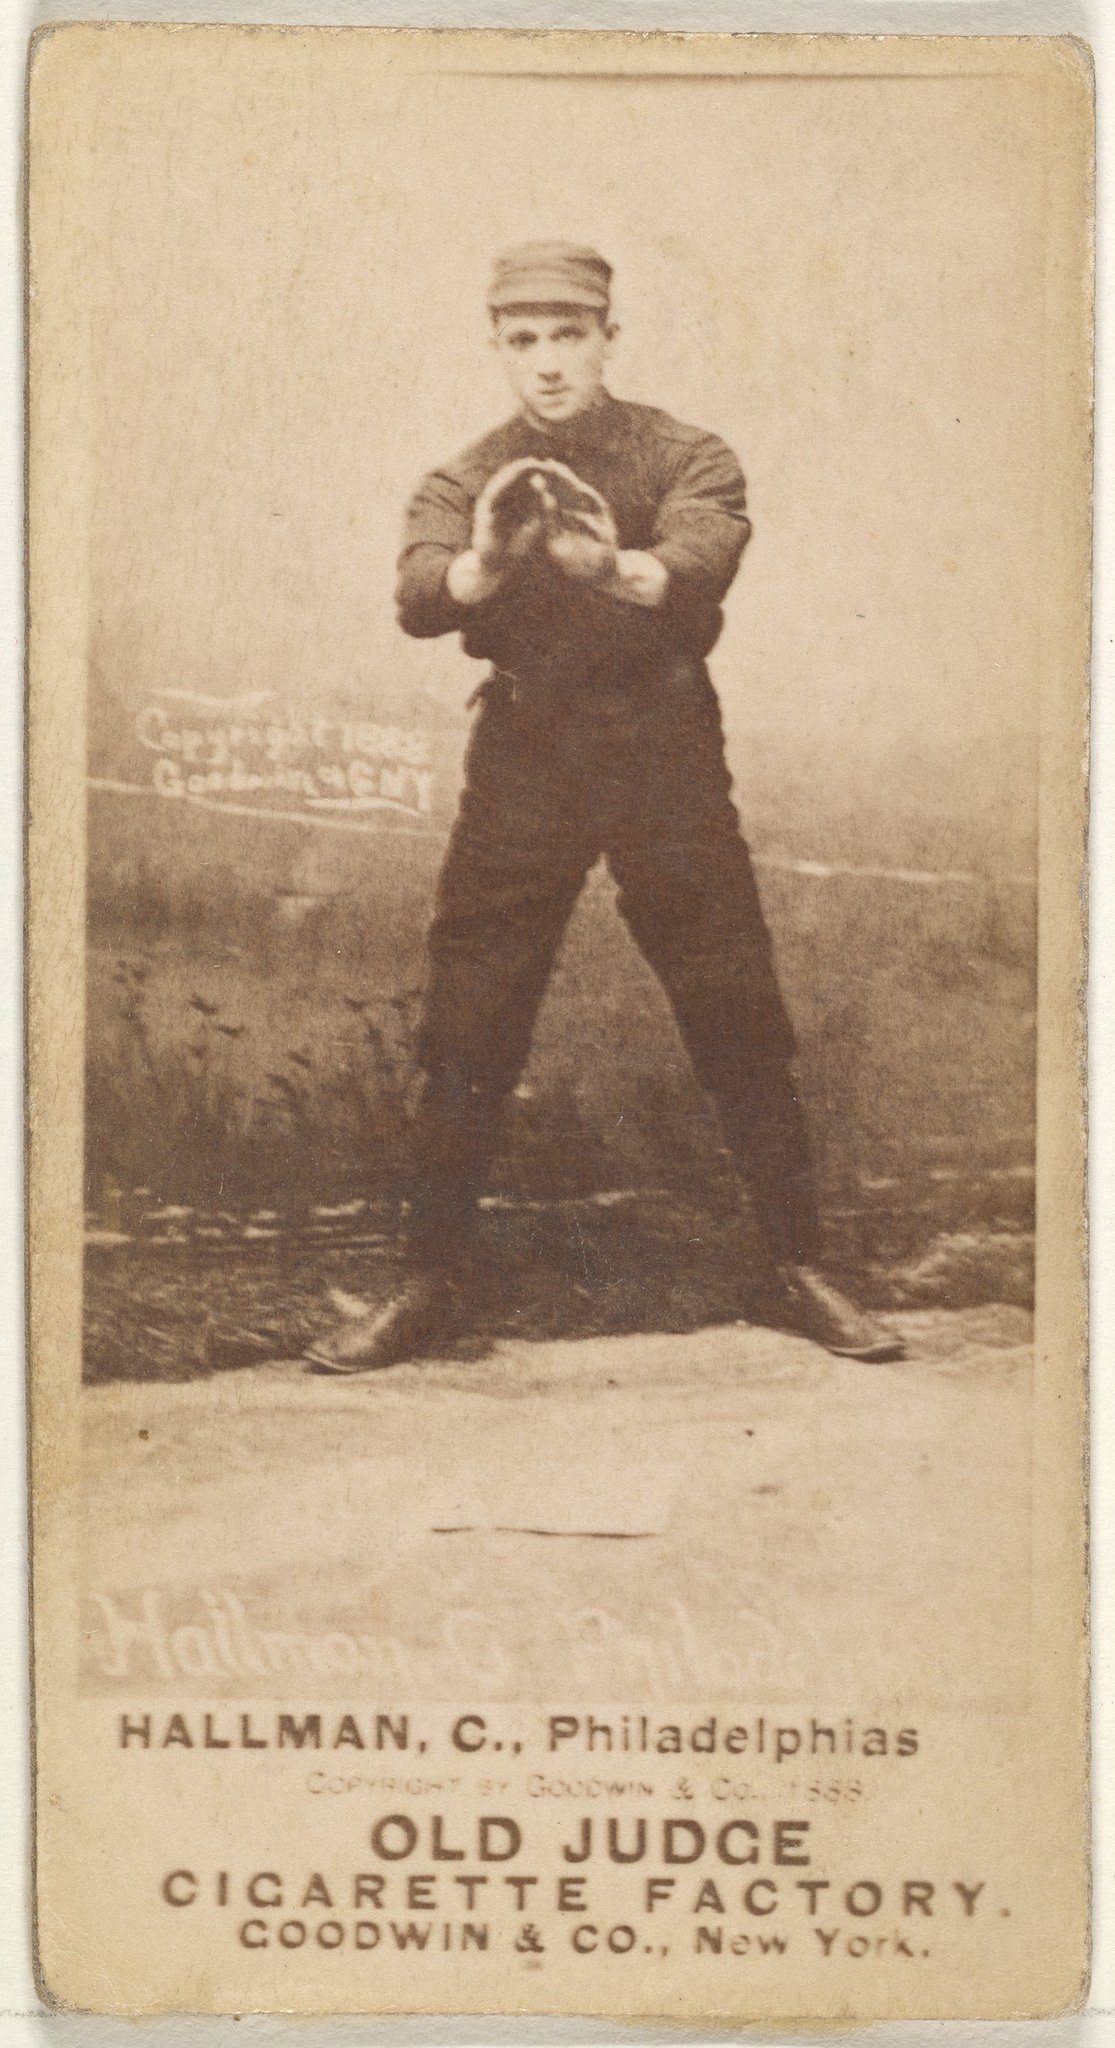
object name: baseball card, photograph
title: William Wilson "Bill" Hallman, Catcher, Philadelphia, from the Old Judge series (N172) for Old Judge Cigarettes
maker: goodwin & company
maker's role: publisher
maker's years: 1850-1950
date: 1888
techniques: albumen silver print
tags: men,portraits,baseball,athletes